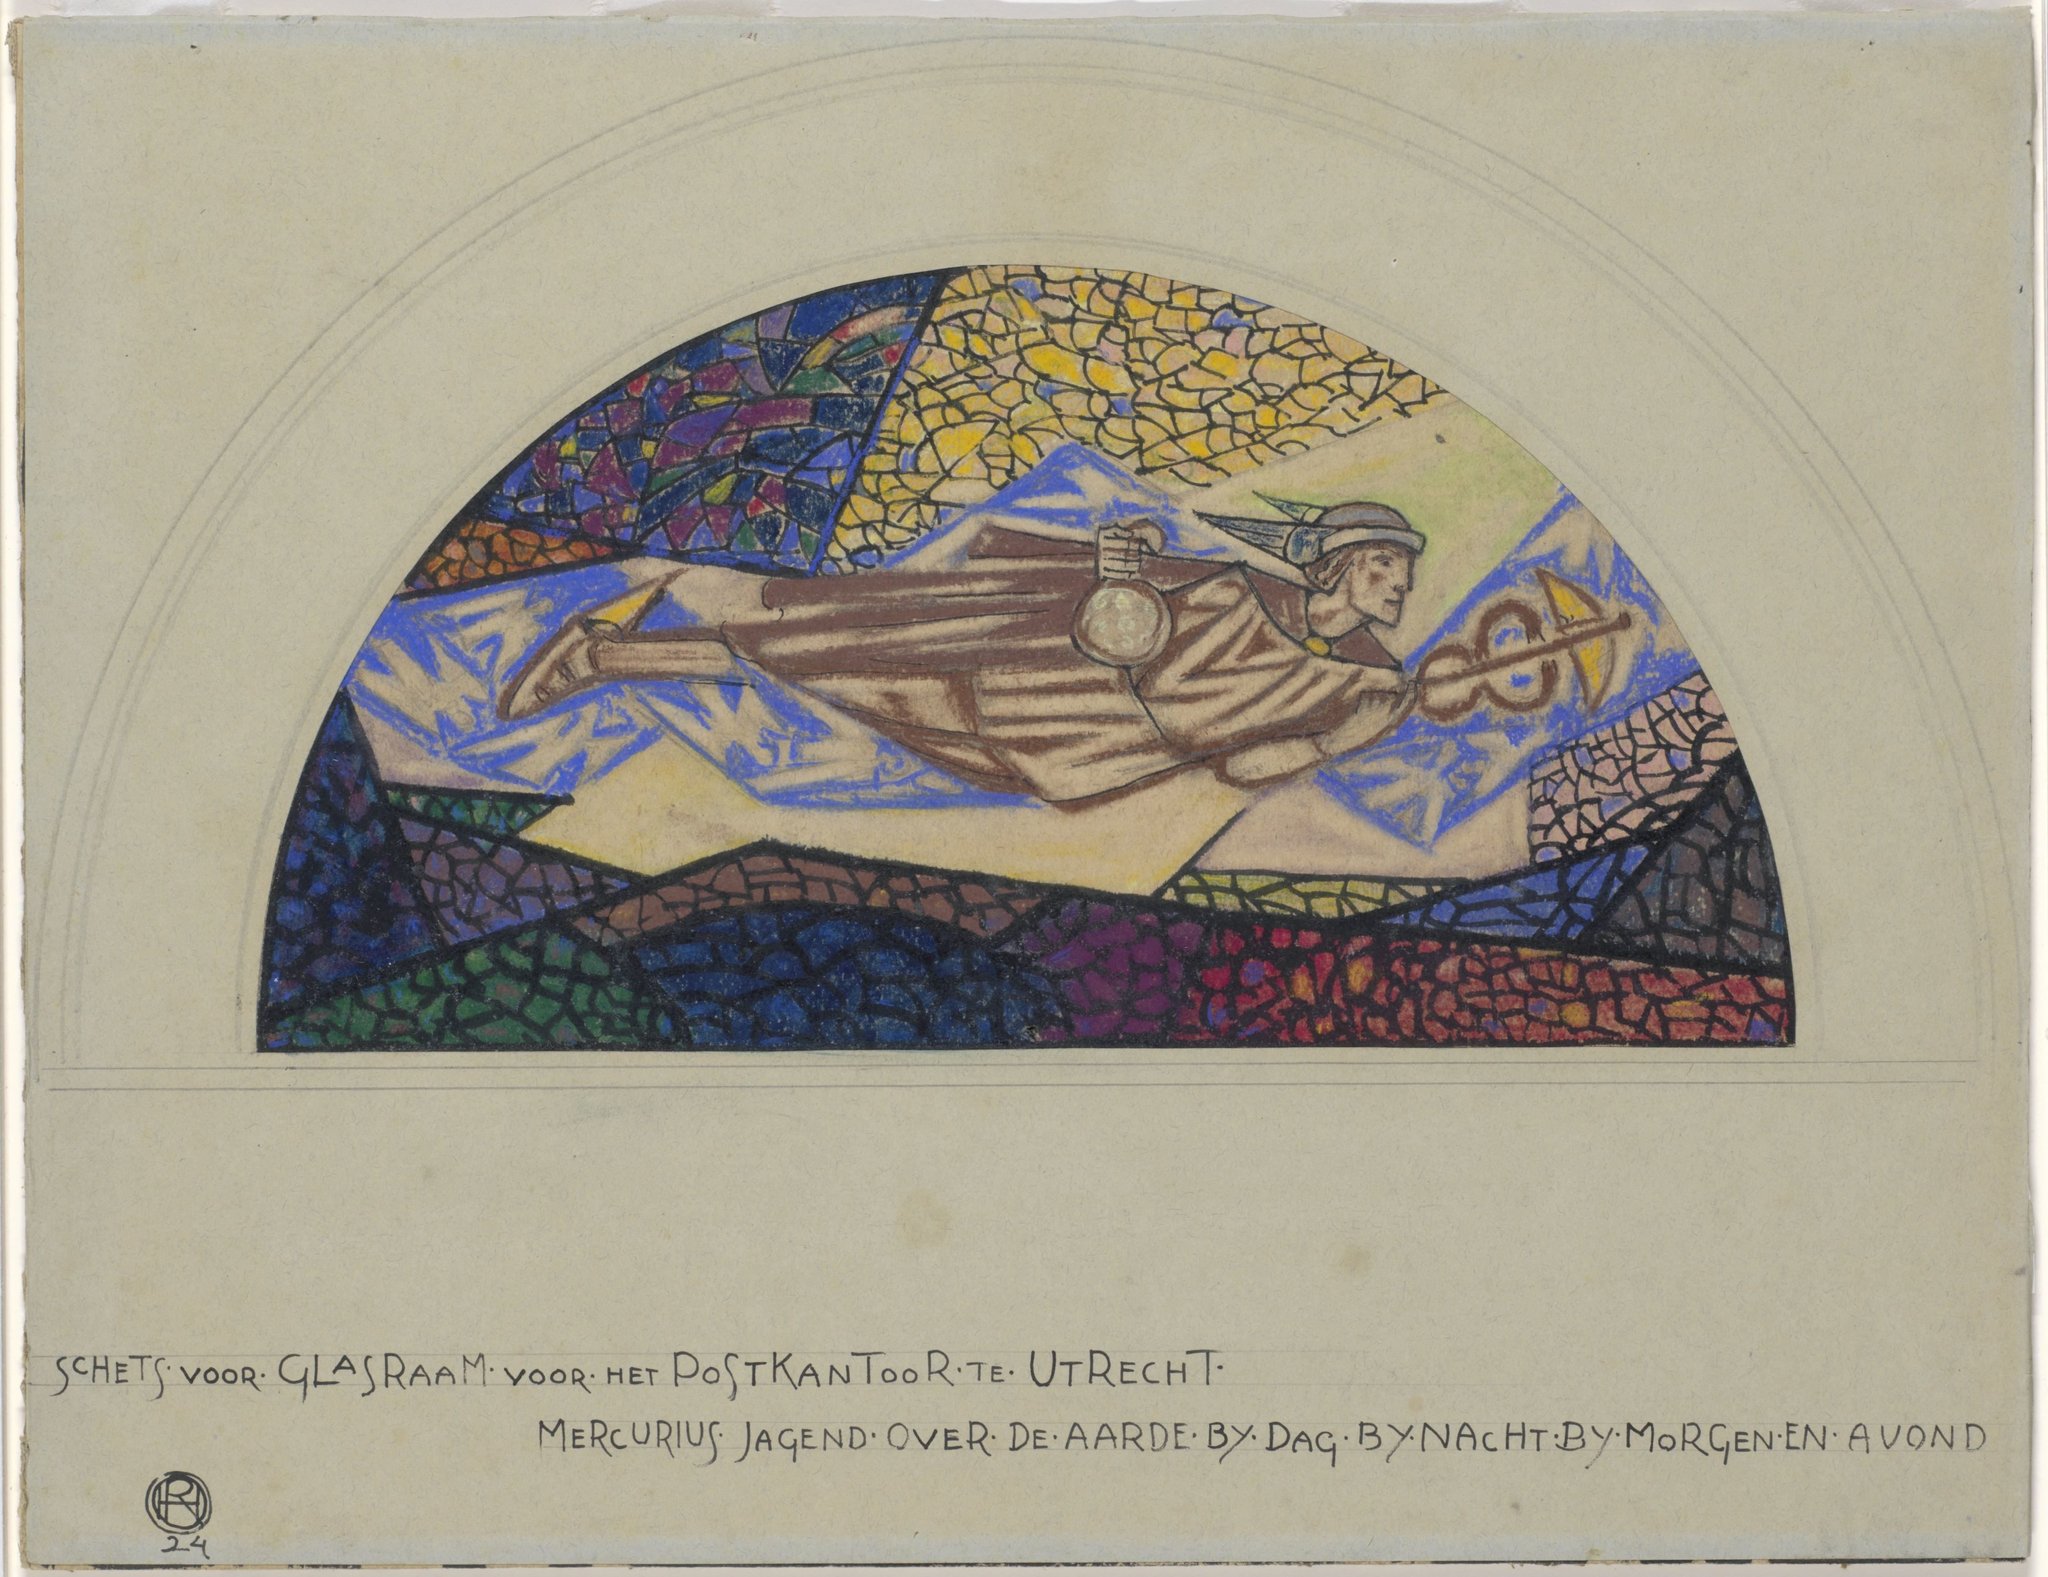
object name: drawing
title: Ontwerp voor raam van het postkantoor te Utrecht: Mercurius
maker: richard nicolaüs roland holst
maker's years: 1868-1938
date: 1924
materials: cardboard, chalk, pastel, pencil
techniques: brush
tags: work of applied art (+ glass ~ arts), (story of) mercury (hermes), utrecht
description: Schets voor Glasraam voor het Postkantoor te Utrecht: Mercurius jagend over de Aarde by Dag by Nacht by Morgen en Avond.